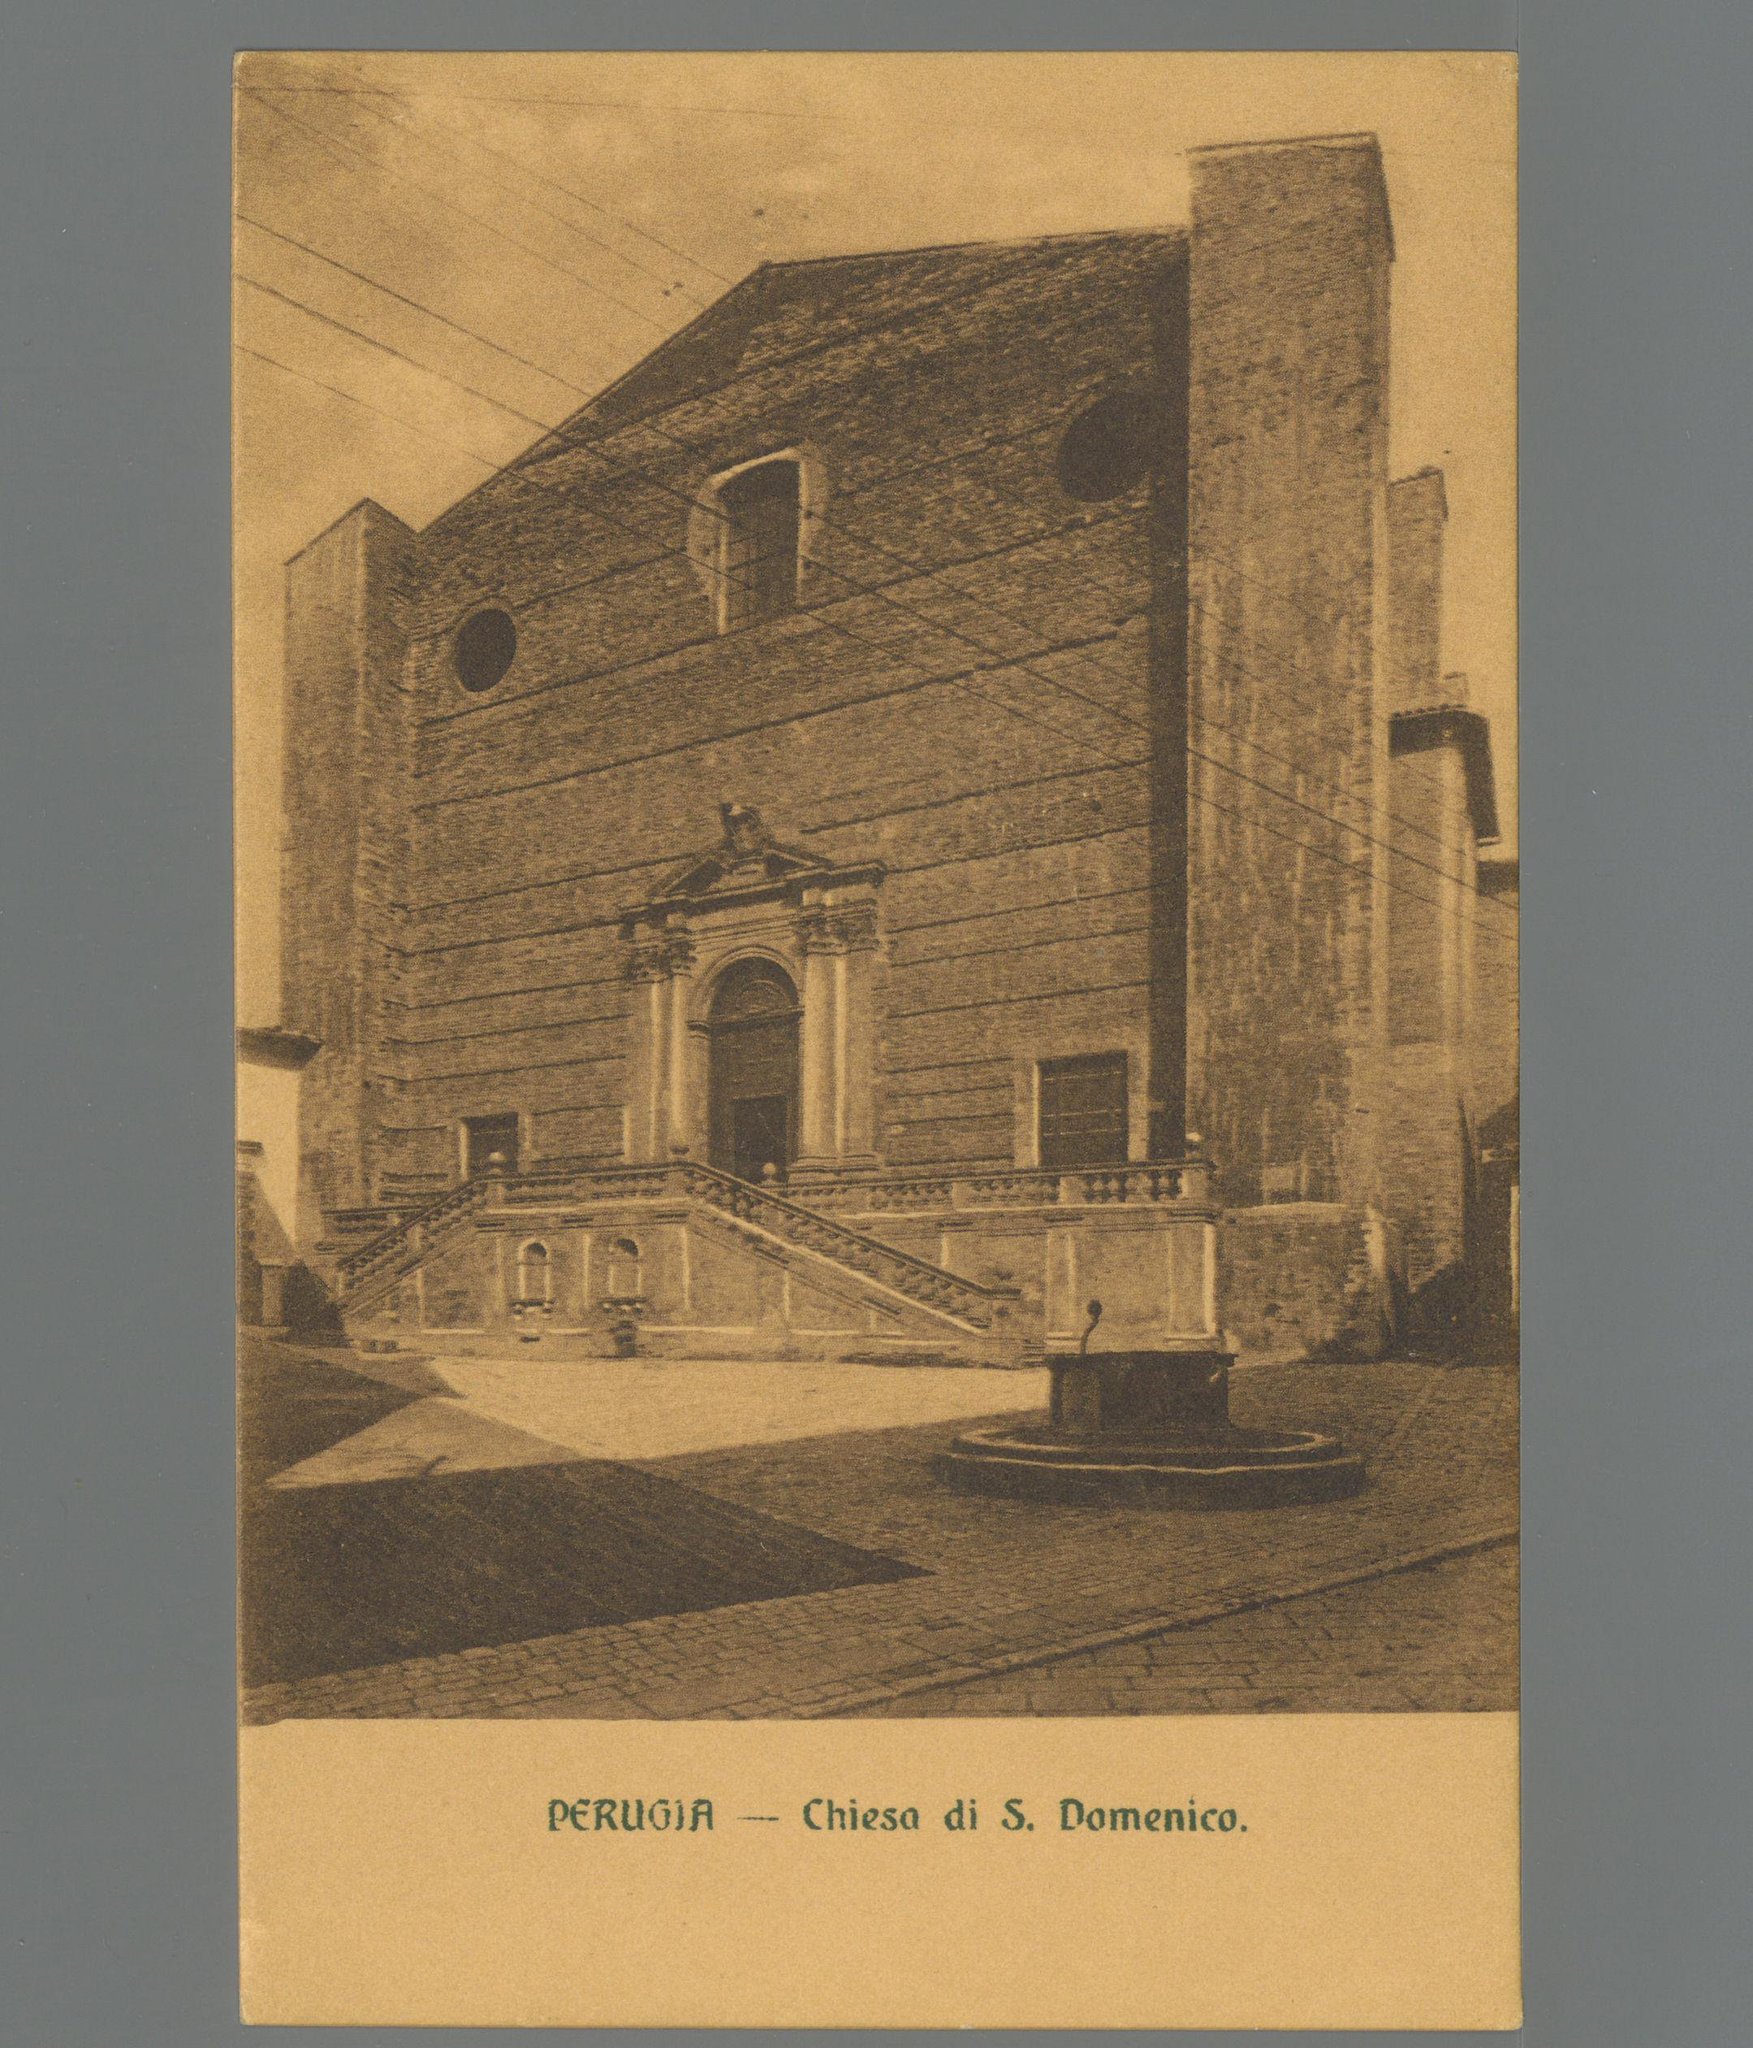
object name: photomechanical print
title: Perugia. Chiesa di S. Domenico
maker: Anonymous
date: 1908-1914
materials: cardboard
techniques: photograph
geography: milan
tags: church (exterior)